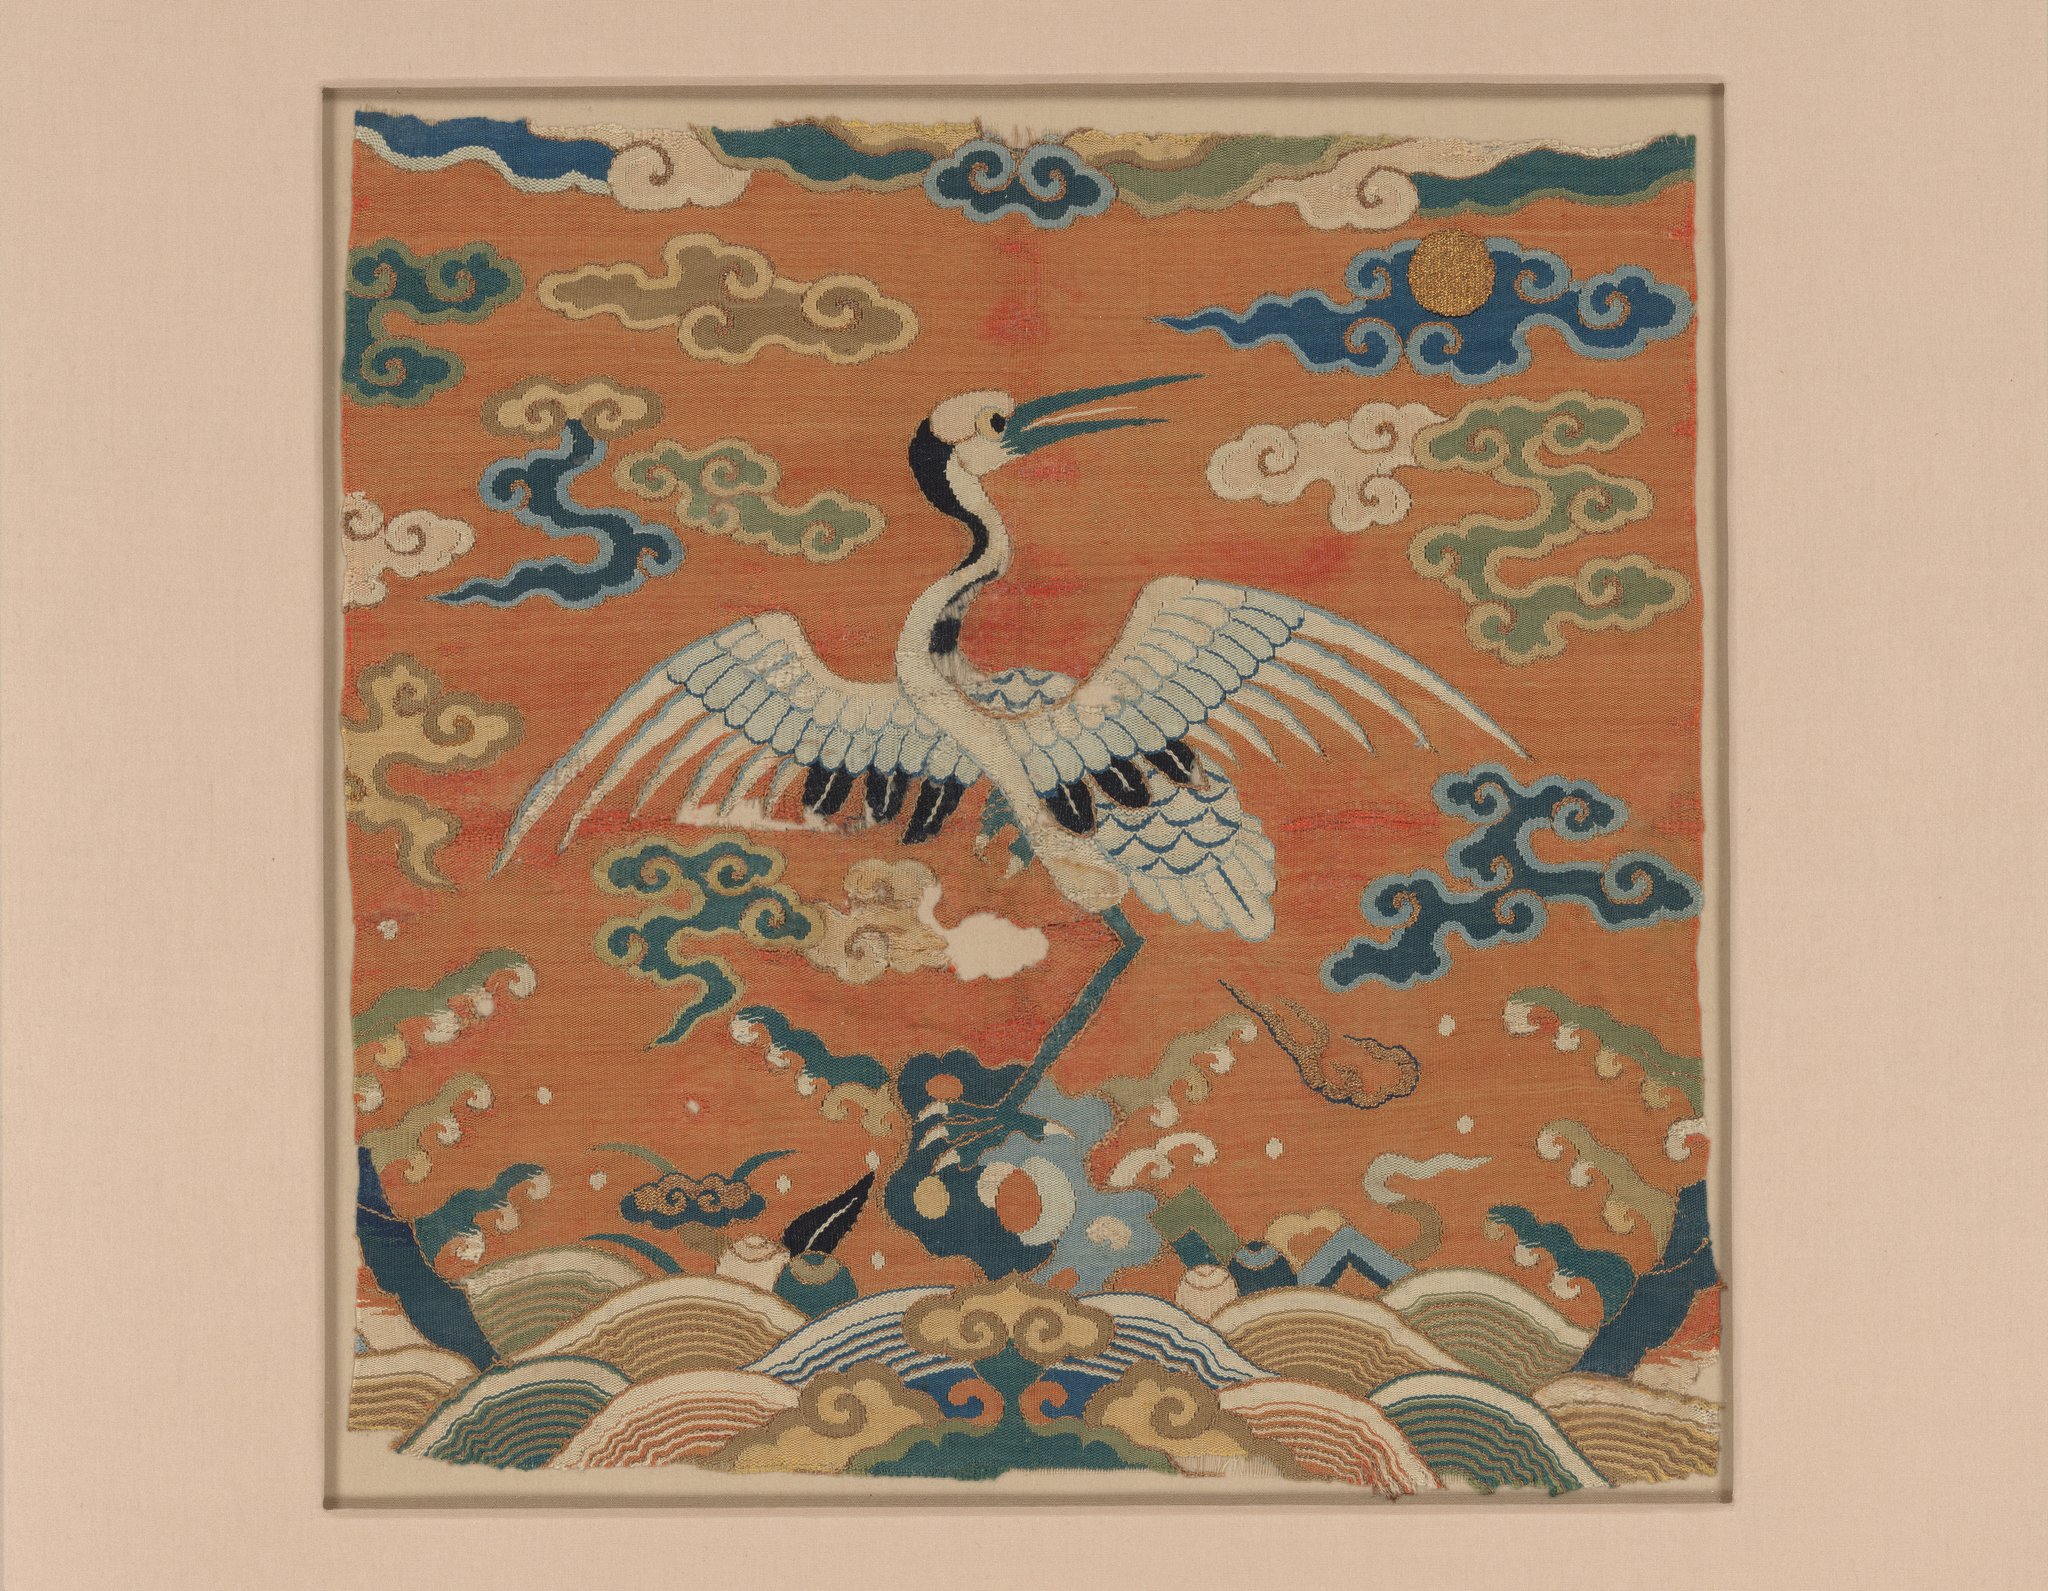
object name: rank badge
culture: chinese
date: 1662-1722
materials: metal thread, silk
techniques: tapestry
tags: cranes